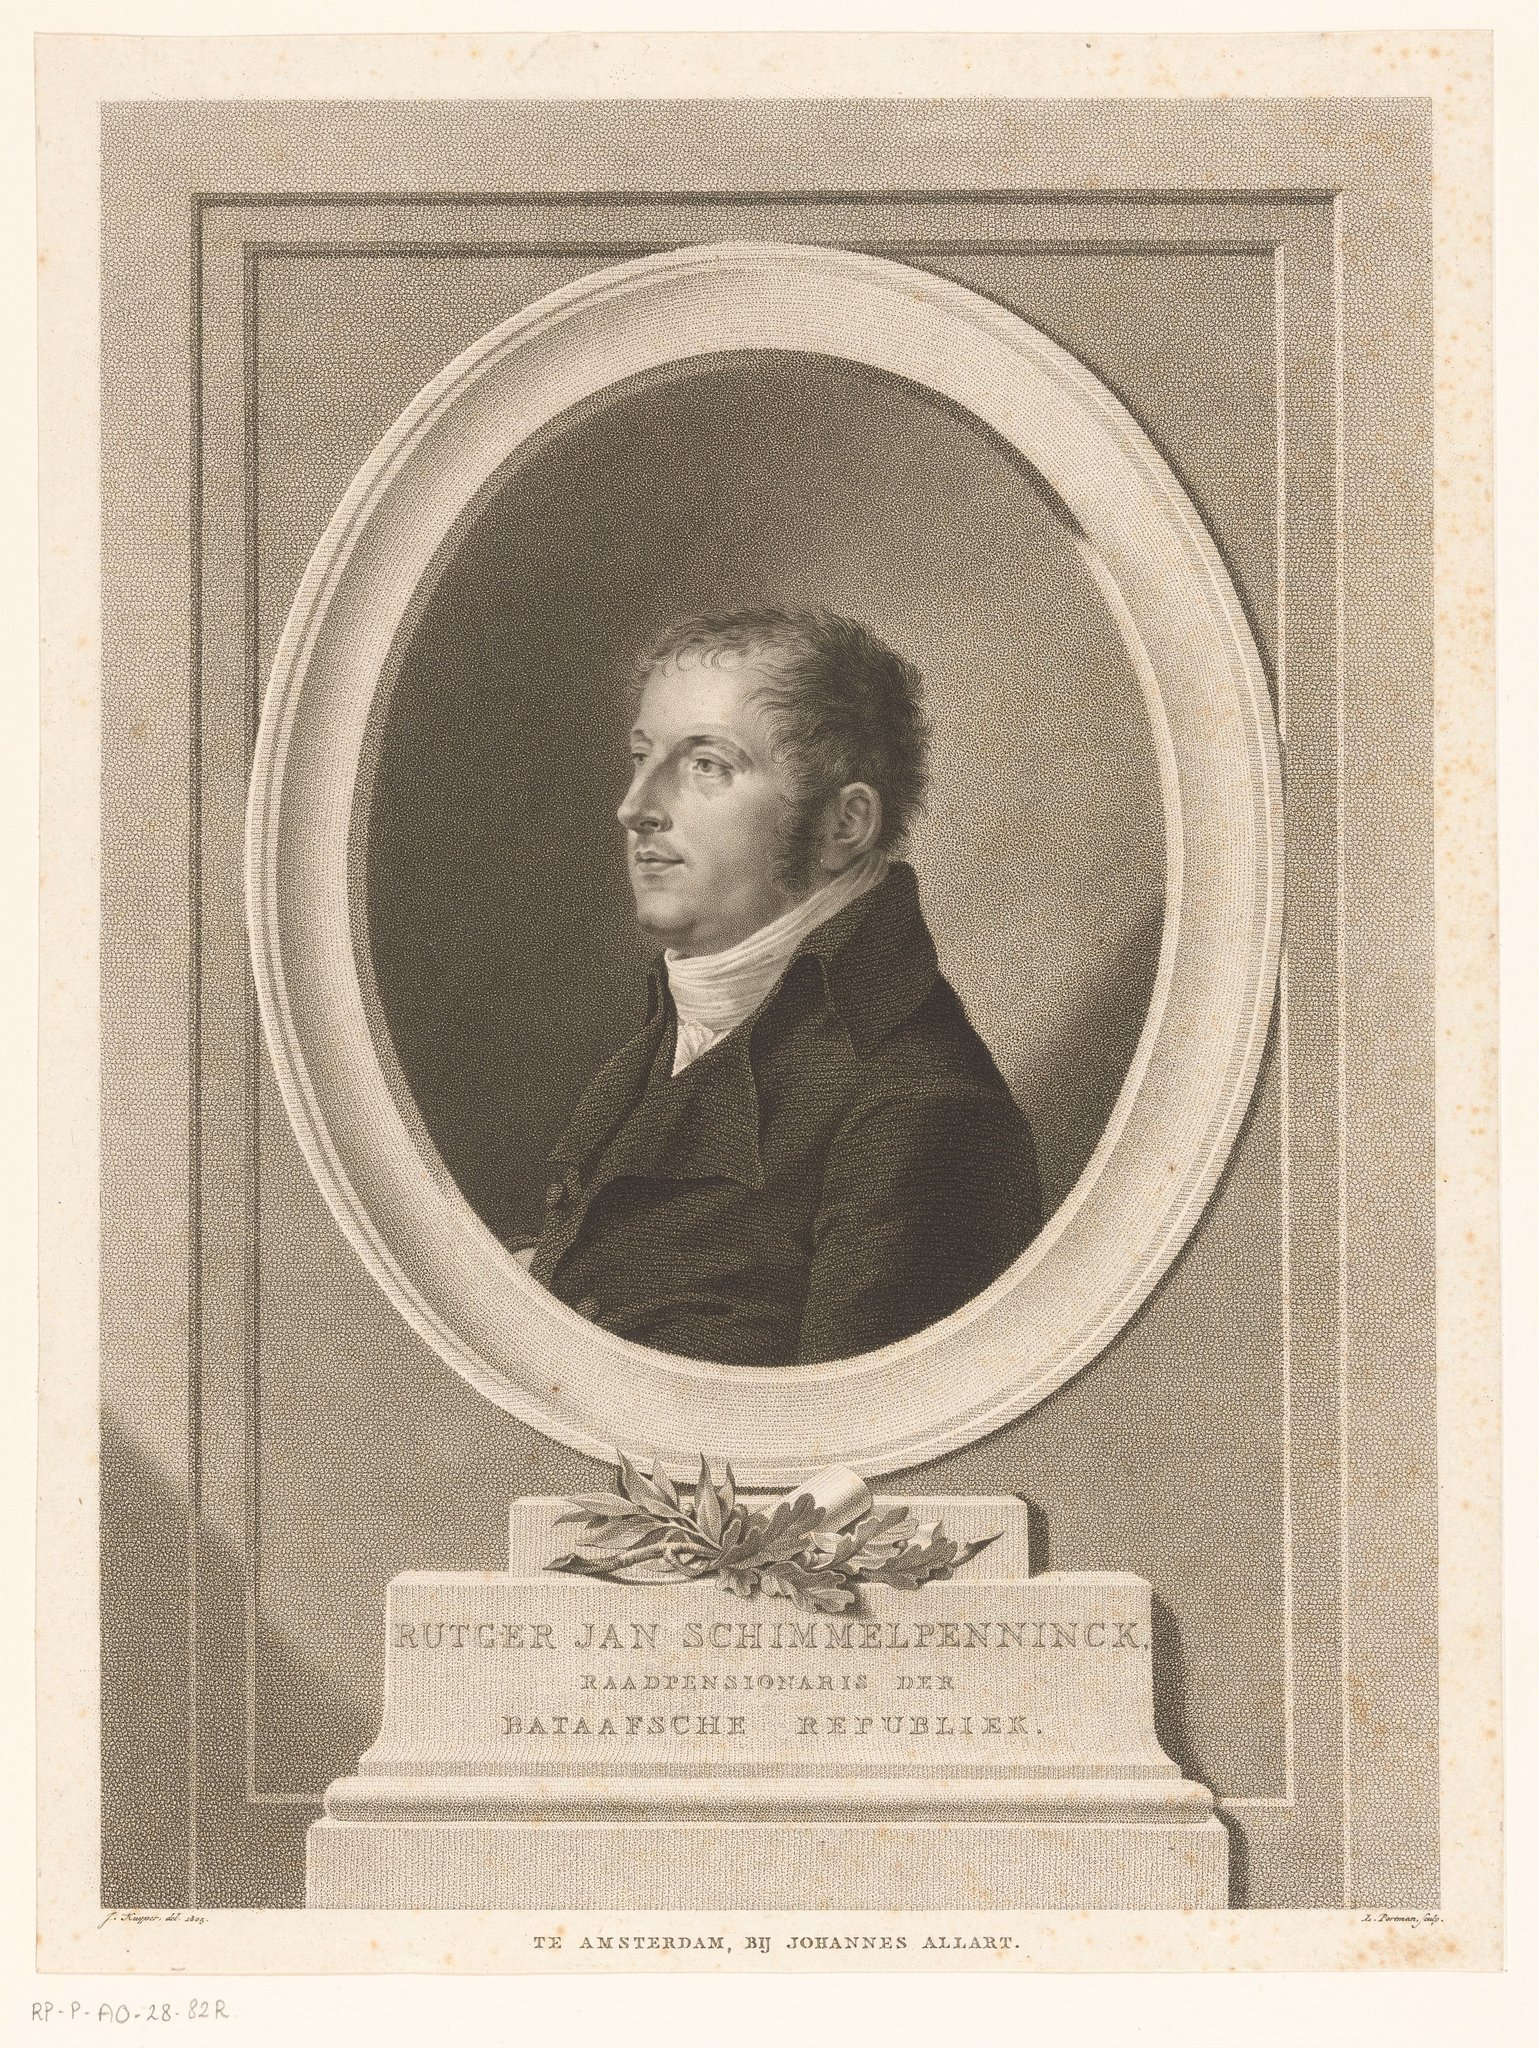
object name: print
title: Portret van Rutger Jan Schimmelpenninck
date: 1805-1817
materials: paper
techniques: engraving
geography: amsterdam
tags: deventer, amsterdam, rutger jan schimmelpenninck (1761-1825), historical persons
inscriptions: collector's mark: Lugt 2228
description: Portret van Rutger Jan Schimmelpenninck, raadspensionaris van de Bataafse Republiek, in een ovaal. Onder het portret zijn naar en functie in drie regels in het Nederlands.